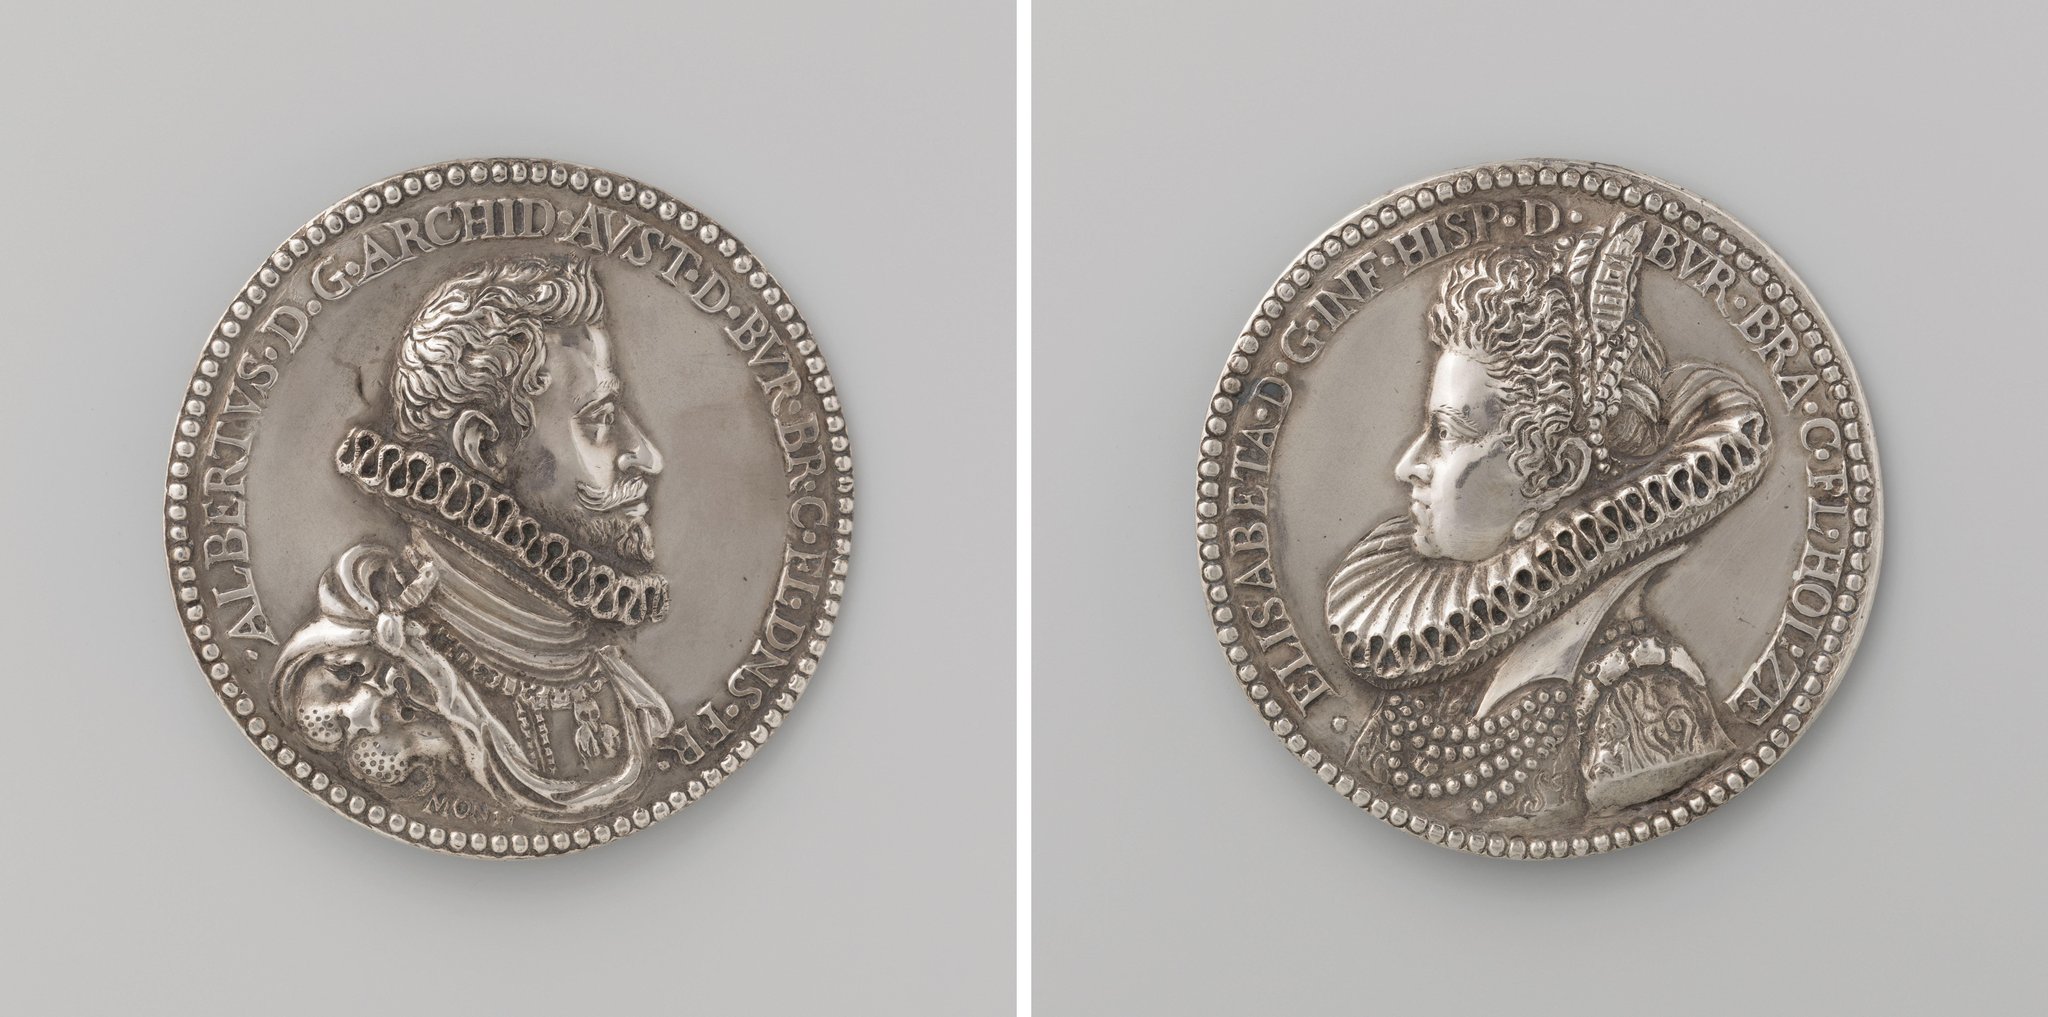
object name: copy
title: Huwelijk van aartshertog Albrecht van Oostenrijk en Isabella, infanta van Spanje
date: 1599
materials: silver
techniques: casting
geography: flanders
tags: infante van spanje isabella clara eugenia, brussels, albrecht aartshertog van oostenrijk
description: Zilveren penning. Voorzijde: borststuk man binnen omschrift. Keerzijde: borststuk vrouw binnen omschrift